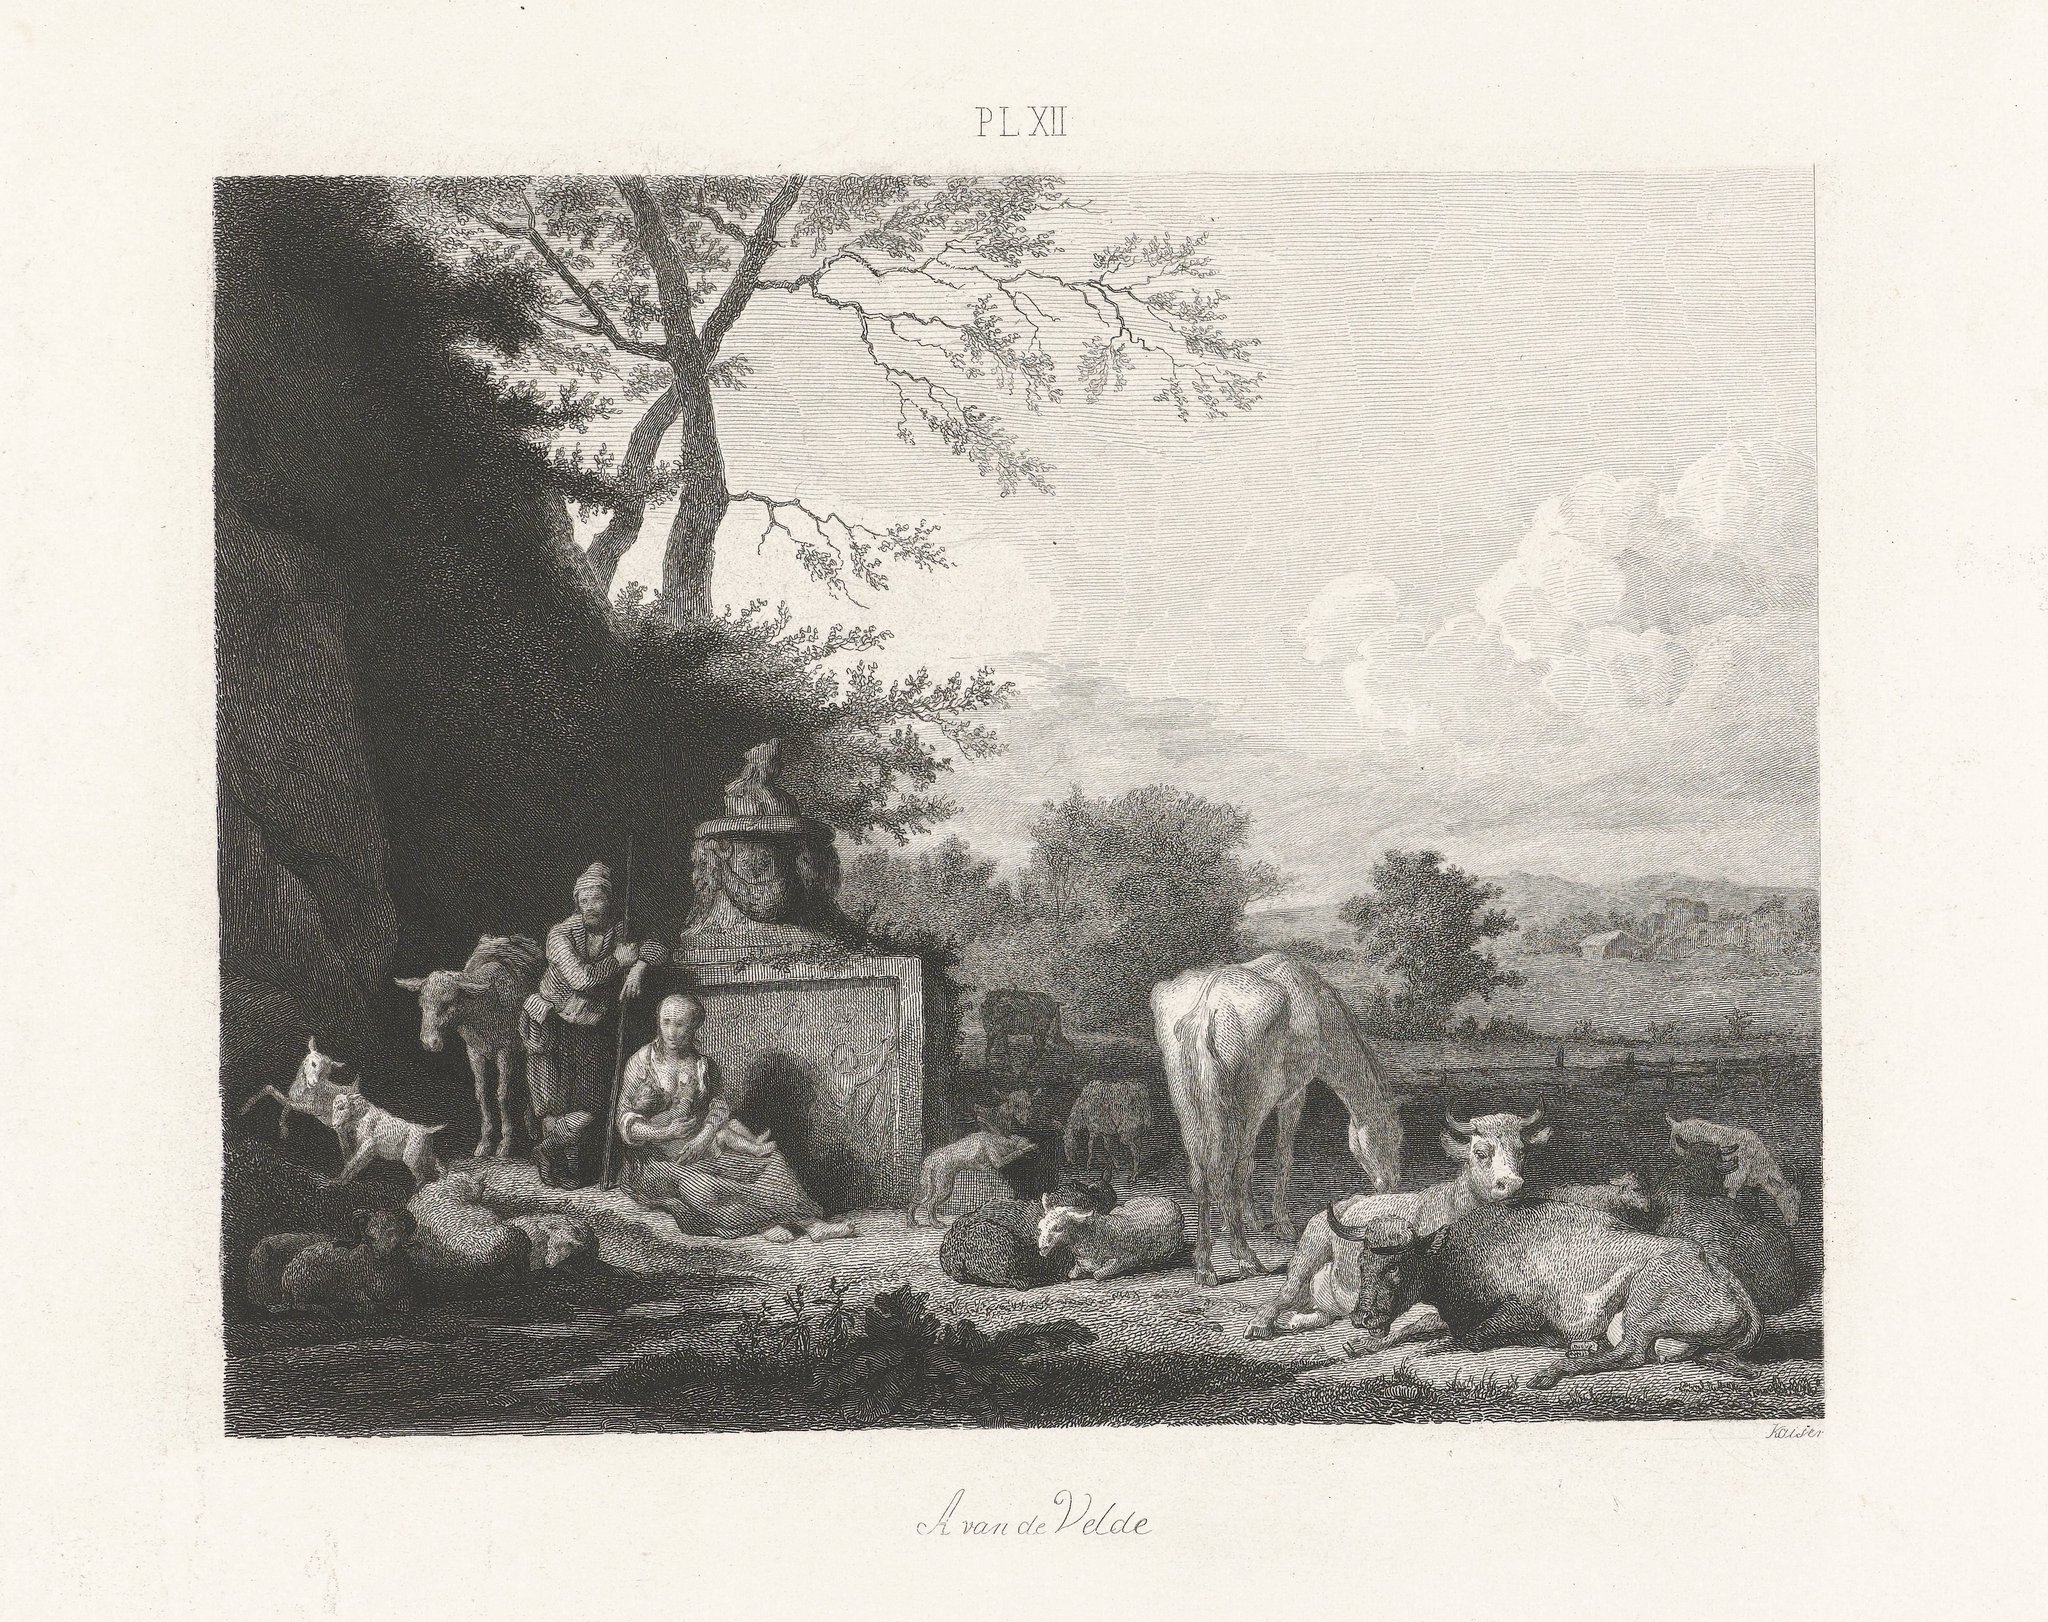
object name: print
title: Arcadisch landschap met rustende herders en vee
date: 1823-1900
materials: paper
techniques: etching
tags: herding, herdsman, herdswoman, shepherd, shepherdess, cowherd, etc.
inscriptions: collector's mark: Lugt 2228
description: Bij een vervallen monument aan de voet van een heuvel rusten een herder en een vrouw; de vrouw heeft een kind aan de borst, de herder staat naast een ezel. Op de voorgrond liggen koeien en schapen, rechts staat een paard. De prent maakt deel uit van een serie van 25 prenten naar Hollandse meesters. Boven de afbeelding: PL XII.